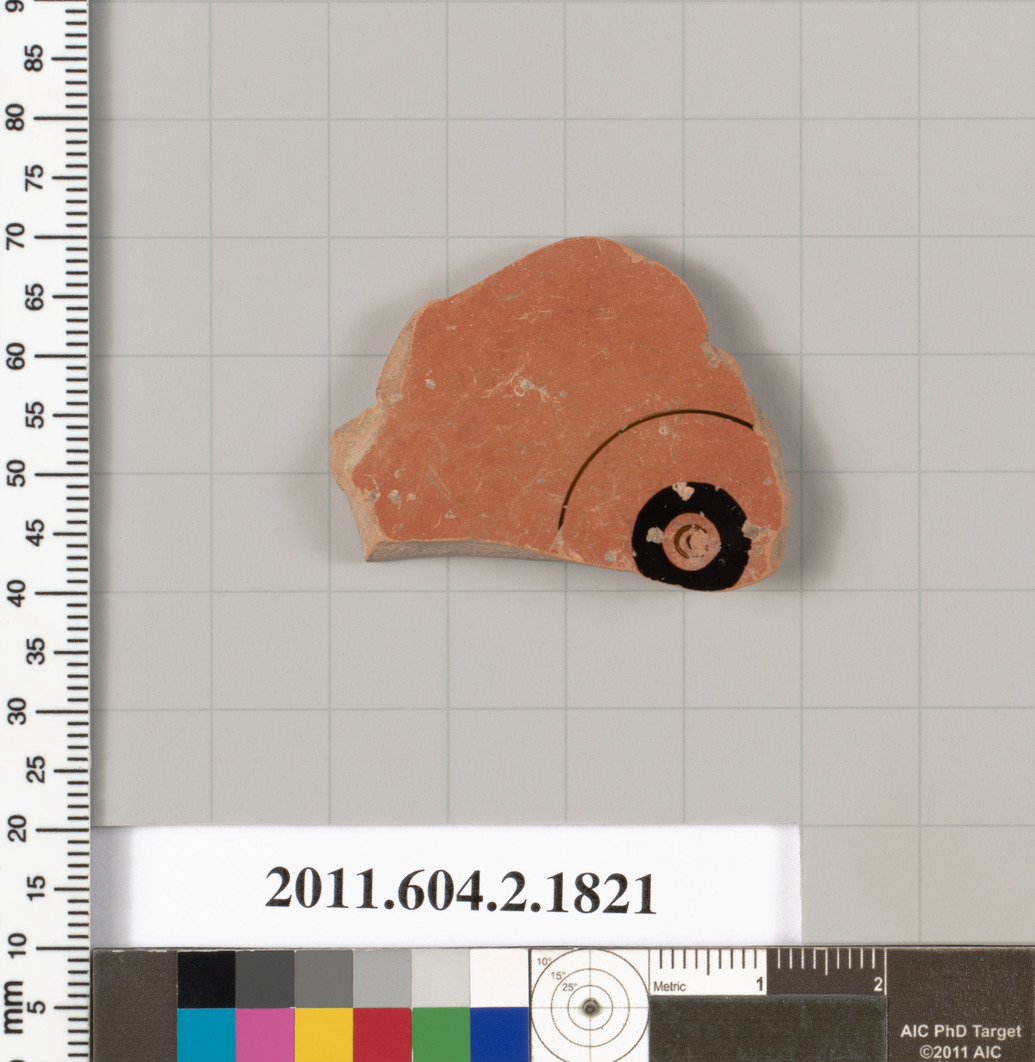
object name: skyphos fragment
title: Terracotta fragment of a skyphos (deep drinking cup)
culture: greek, attic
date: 475-451 BCE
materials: terracotta